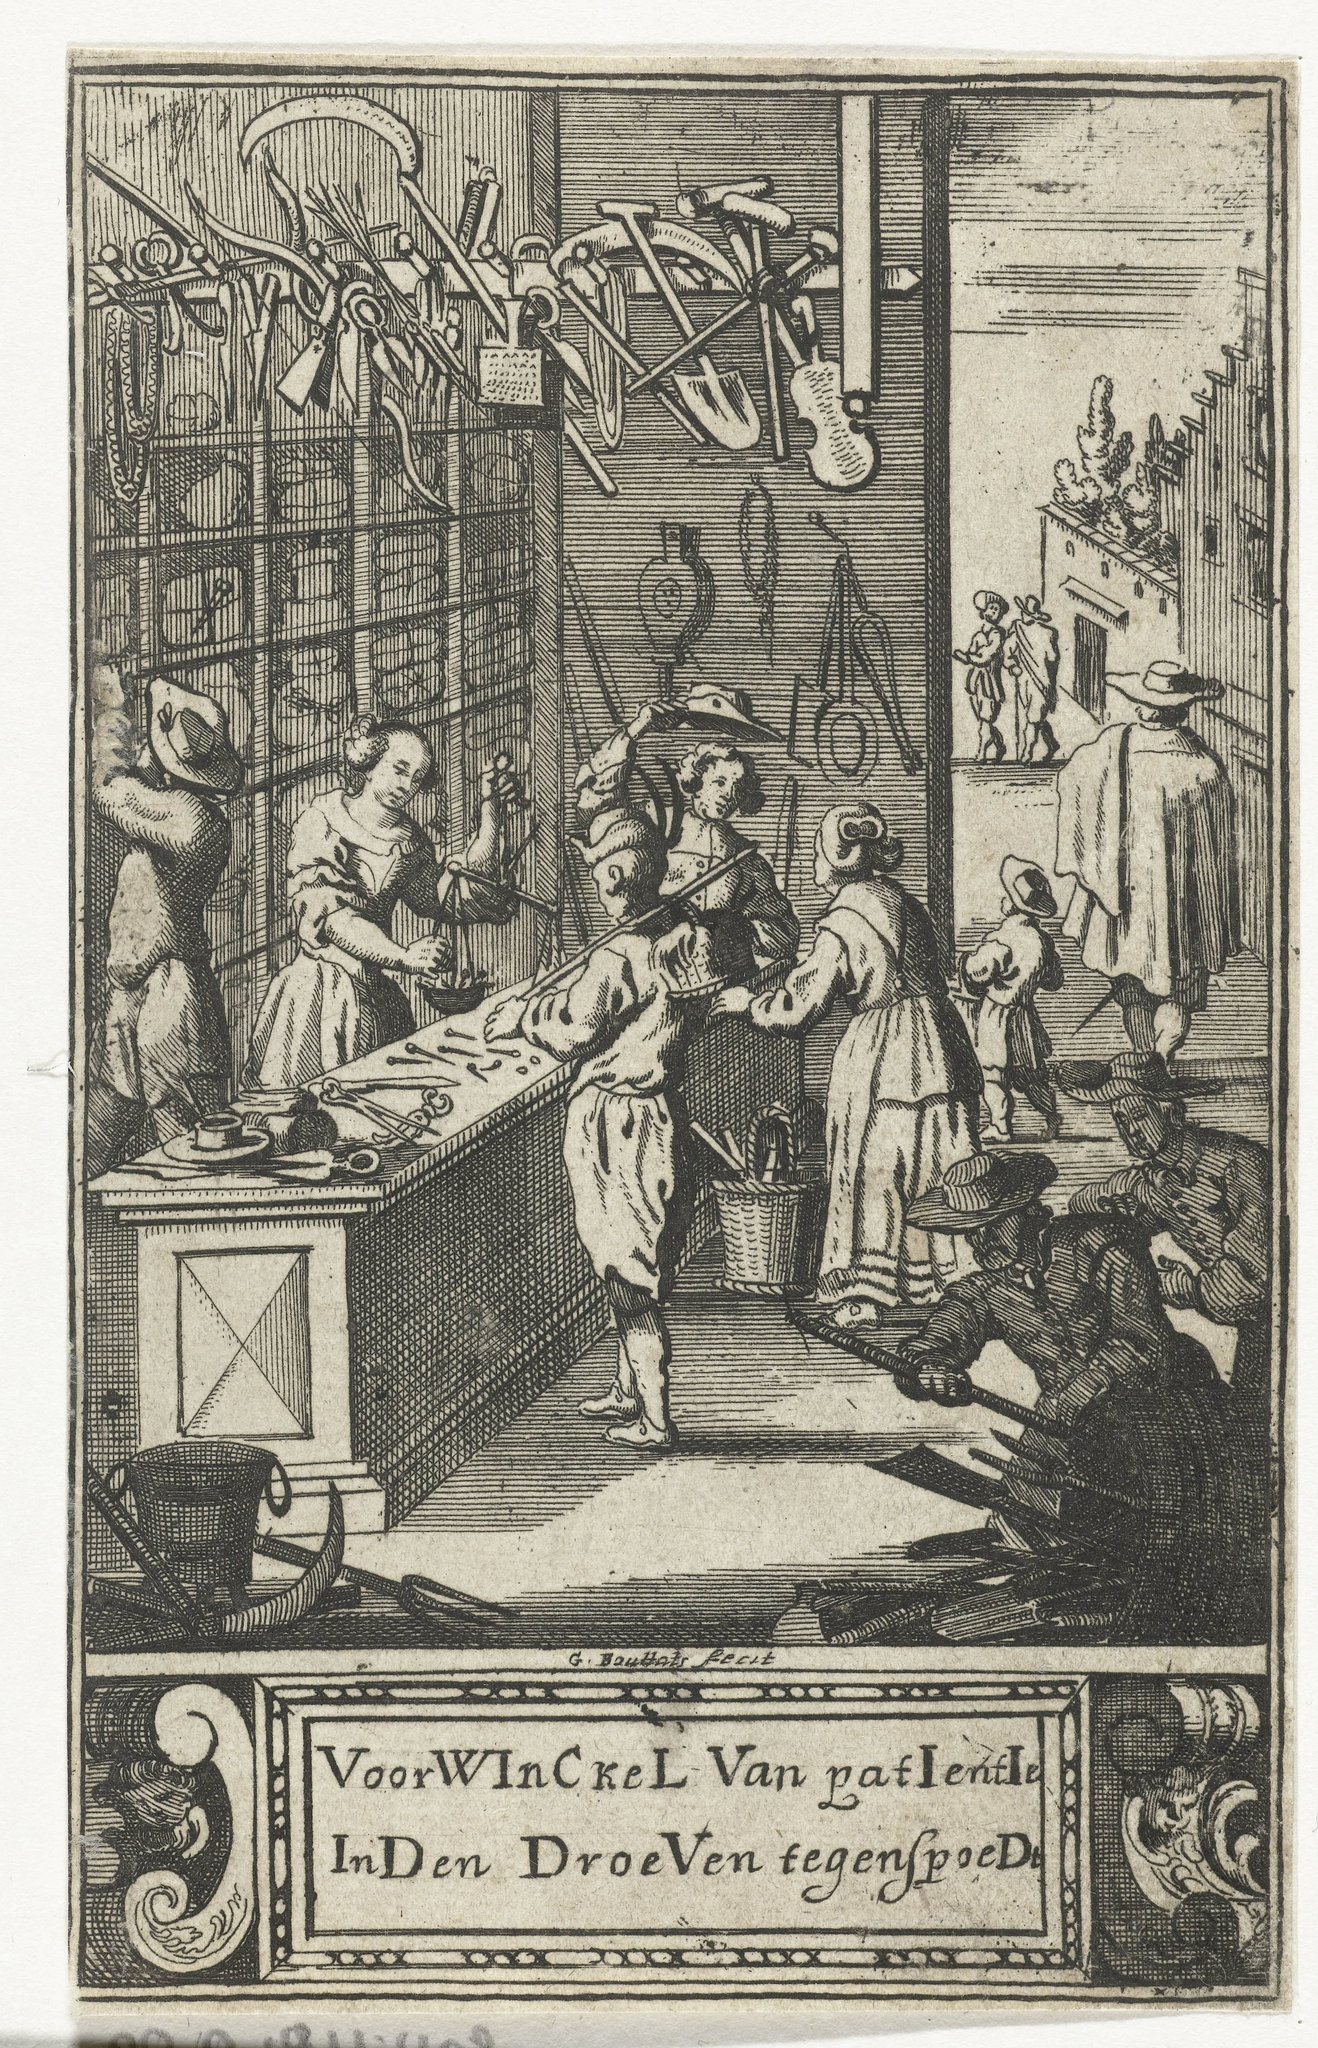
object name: print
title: Titelpagina voor: Franciscus Lijftocht, Voor-winckel van patientie in den droeven tegenspoedt (…), 1679-1681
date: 1679-1681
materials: paper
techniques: engraving, etching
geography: antwerp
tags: tools, aids, implements ~ crafts and industries, shop, store, title-page, adversity, misfortune, bad luck; 'fortuna infelice', 'infortunio' (ripa)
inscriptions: collector's mark: Lugt 2228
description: De prent toont het interieur van een gereedschapswinkel. Allerlei soorten werktuigen worden hier verkocht: scharen, weegschalen, zeisen, rieken, spades, hamers, tangen, etc. Drie winkeliers achter de balie helpen enkele klanten. Een open deur laat een straatgezicht zien. Allegorisch wordt zo duidelijk gemaakt dat het boekje de werktuigen biedt om om te gaan met tegenslagen in het leven. Onder de afbeelding is een cartouche met de titel van het boek.